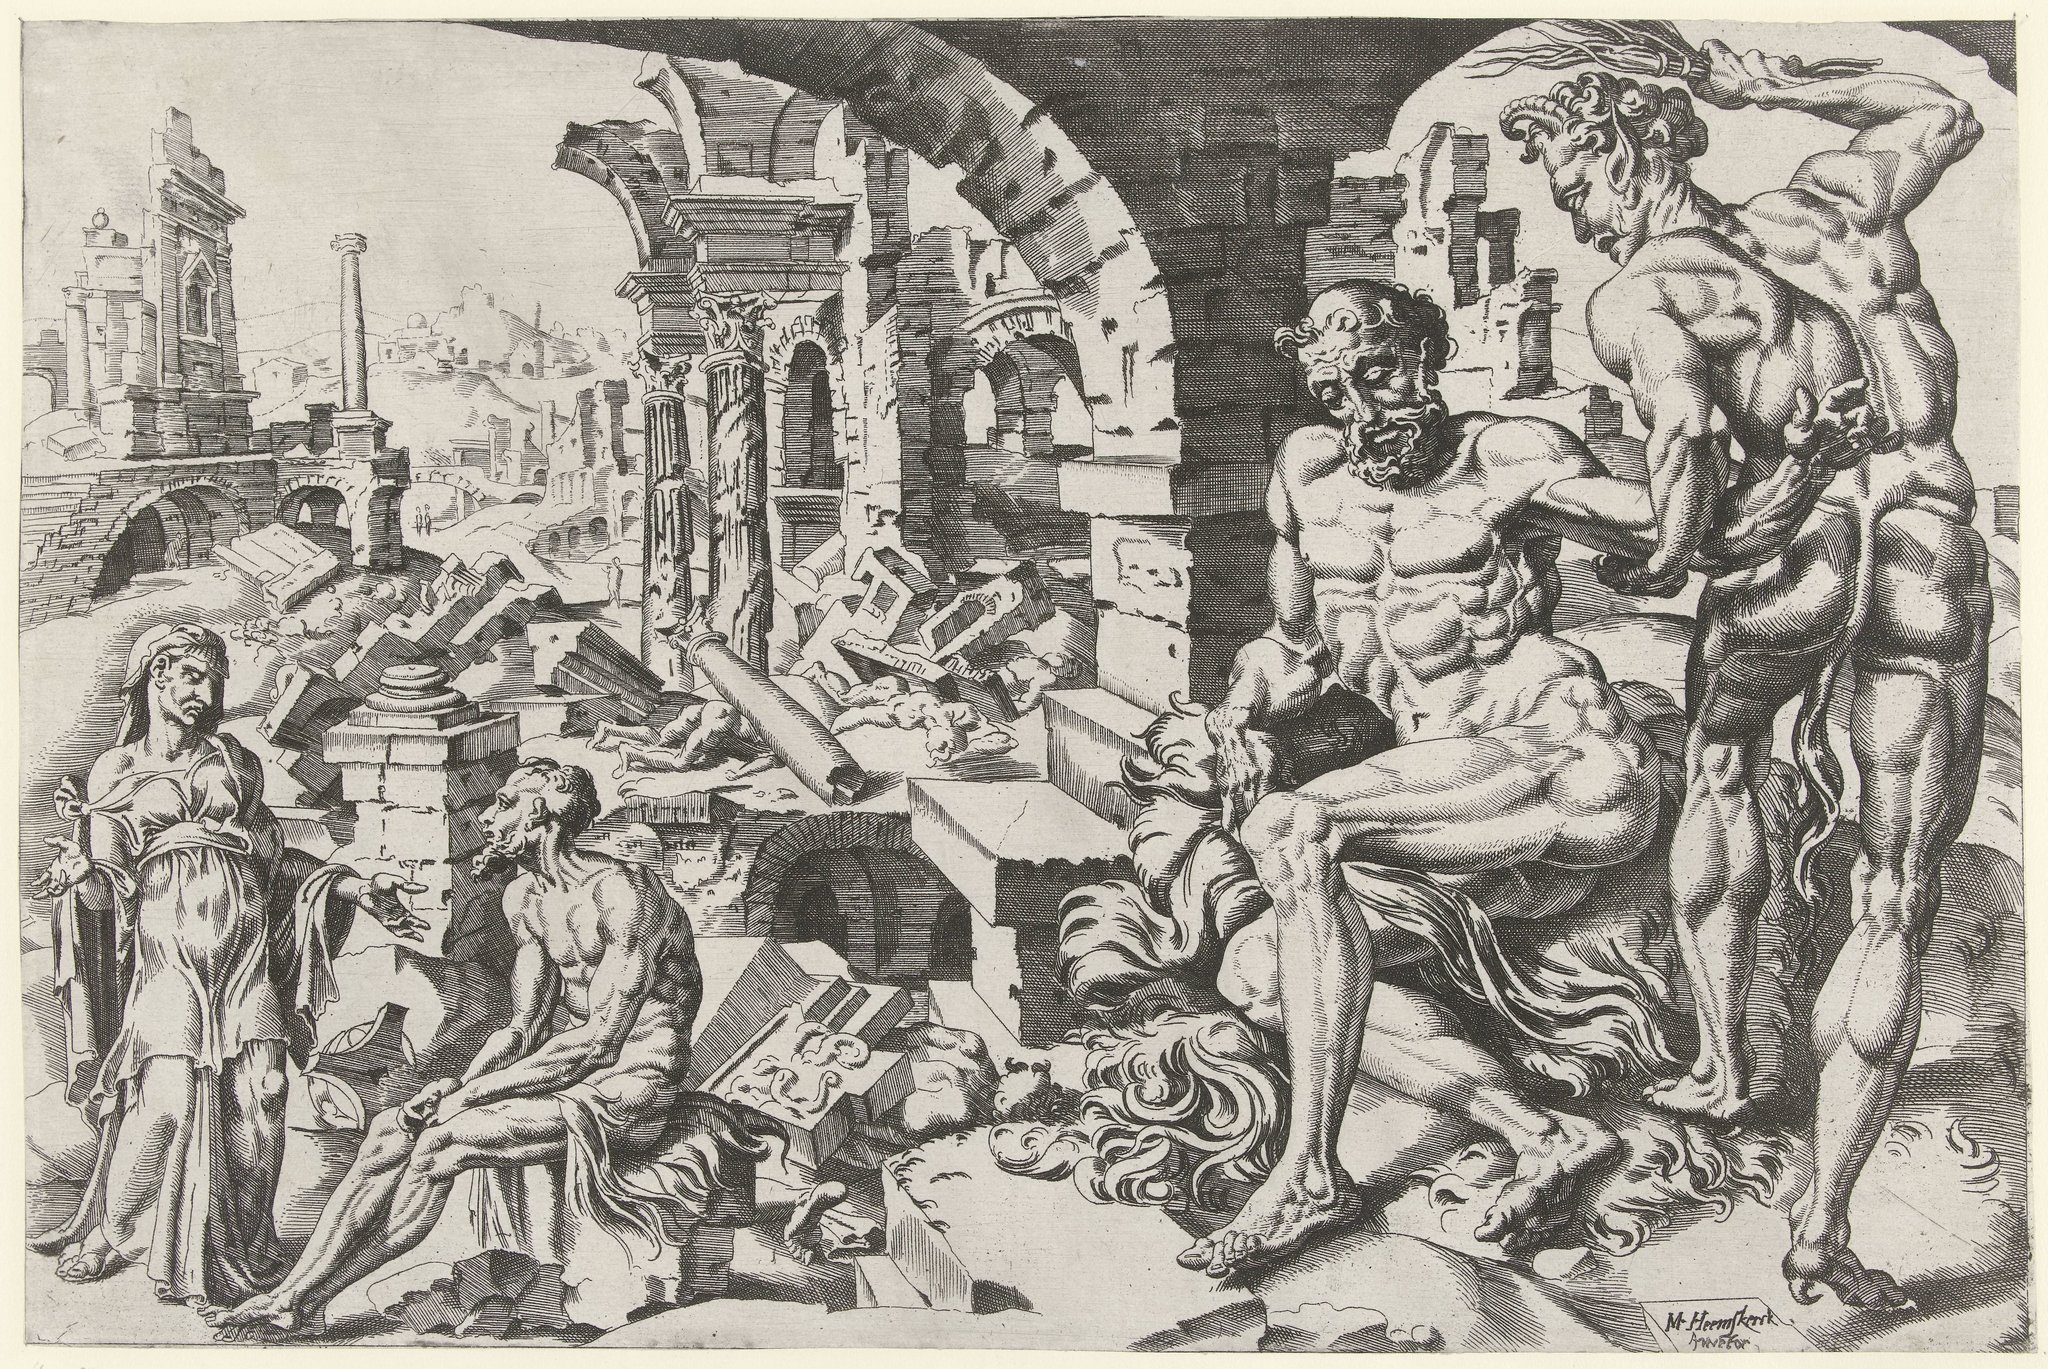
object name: print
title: Job wordt door Satan gegeseld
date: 1548-1550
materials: paper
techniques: etching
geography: haarlem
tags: job's wife abusing him; satan may be present, the last messenger announces the death of job's children, killed in a storm which razed the house in which they were having a feast, satan scourging job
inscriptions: collector's mark: Lugt 2228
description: Rechts op de voorgrond zit Job op een steen. Satan geselt hem met een roede en geeft hem zweren. Links wordt Job door zijn vrouw bespot. Op de achtergrond liggen de lijken van Jobs kinderen tussen de brokstukken en zuilen van zijn huis.